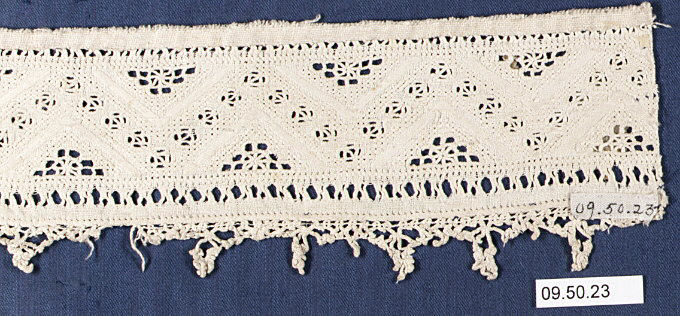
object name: strip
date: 1801-1900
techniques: lace, embroidery